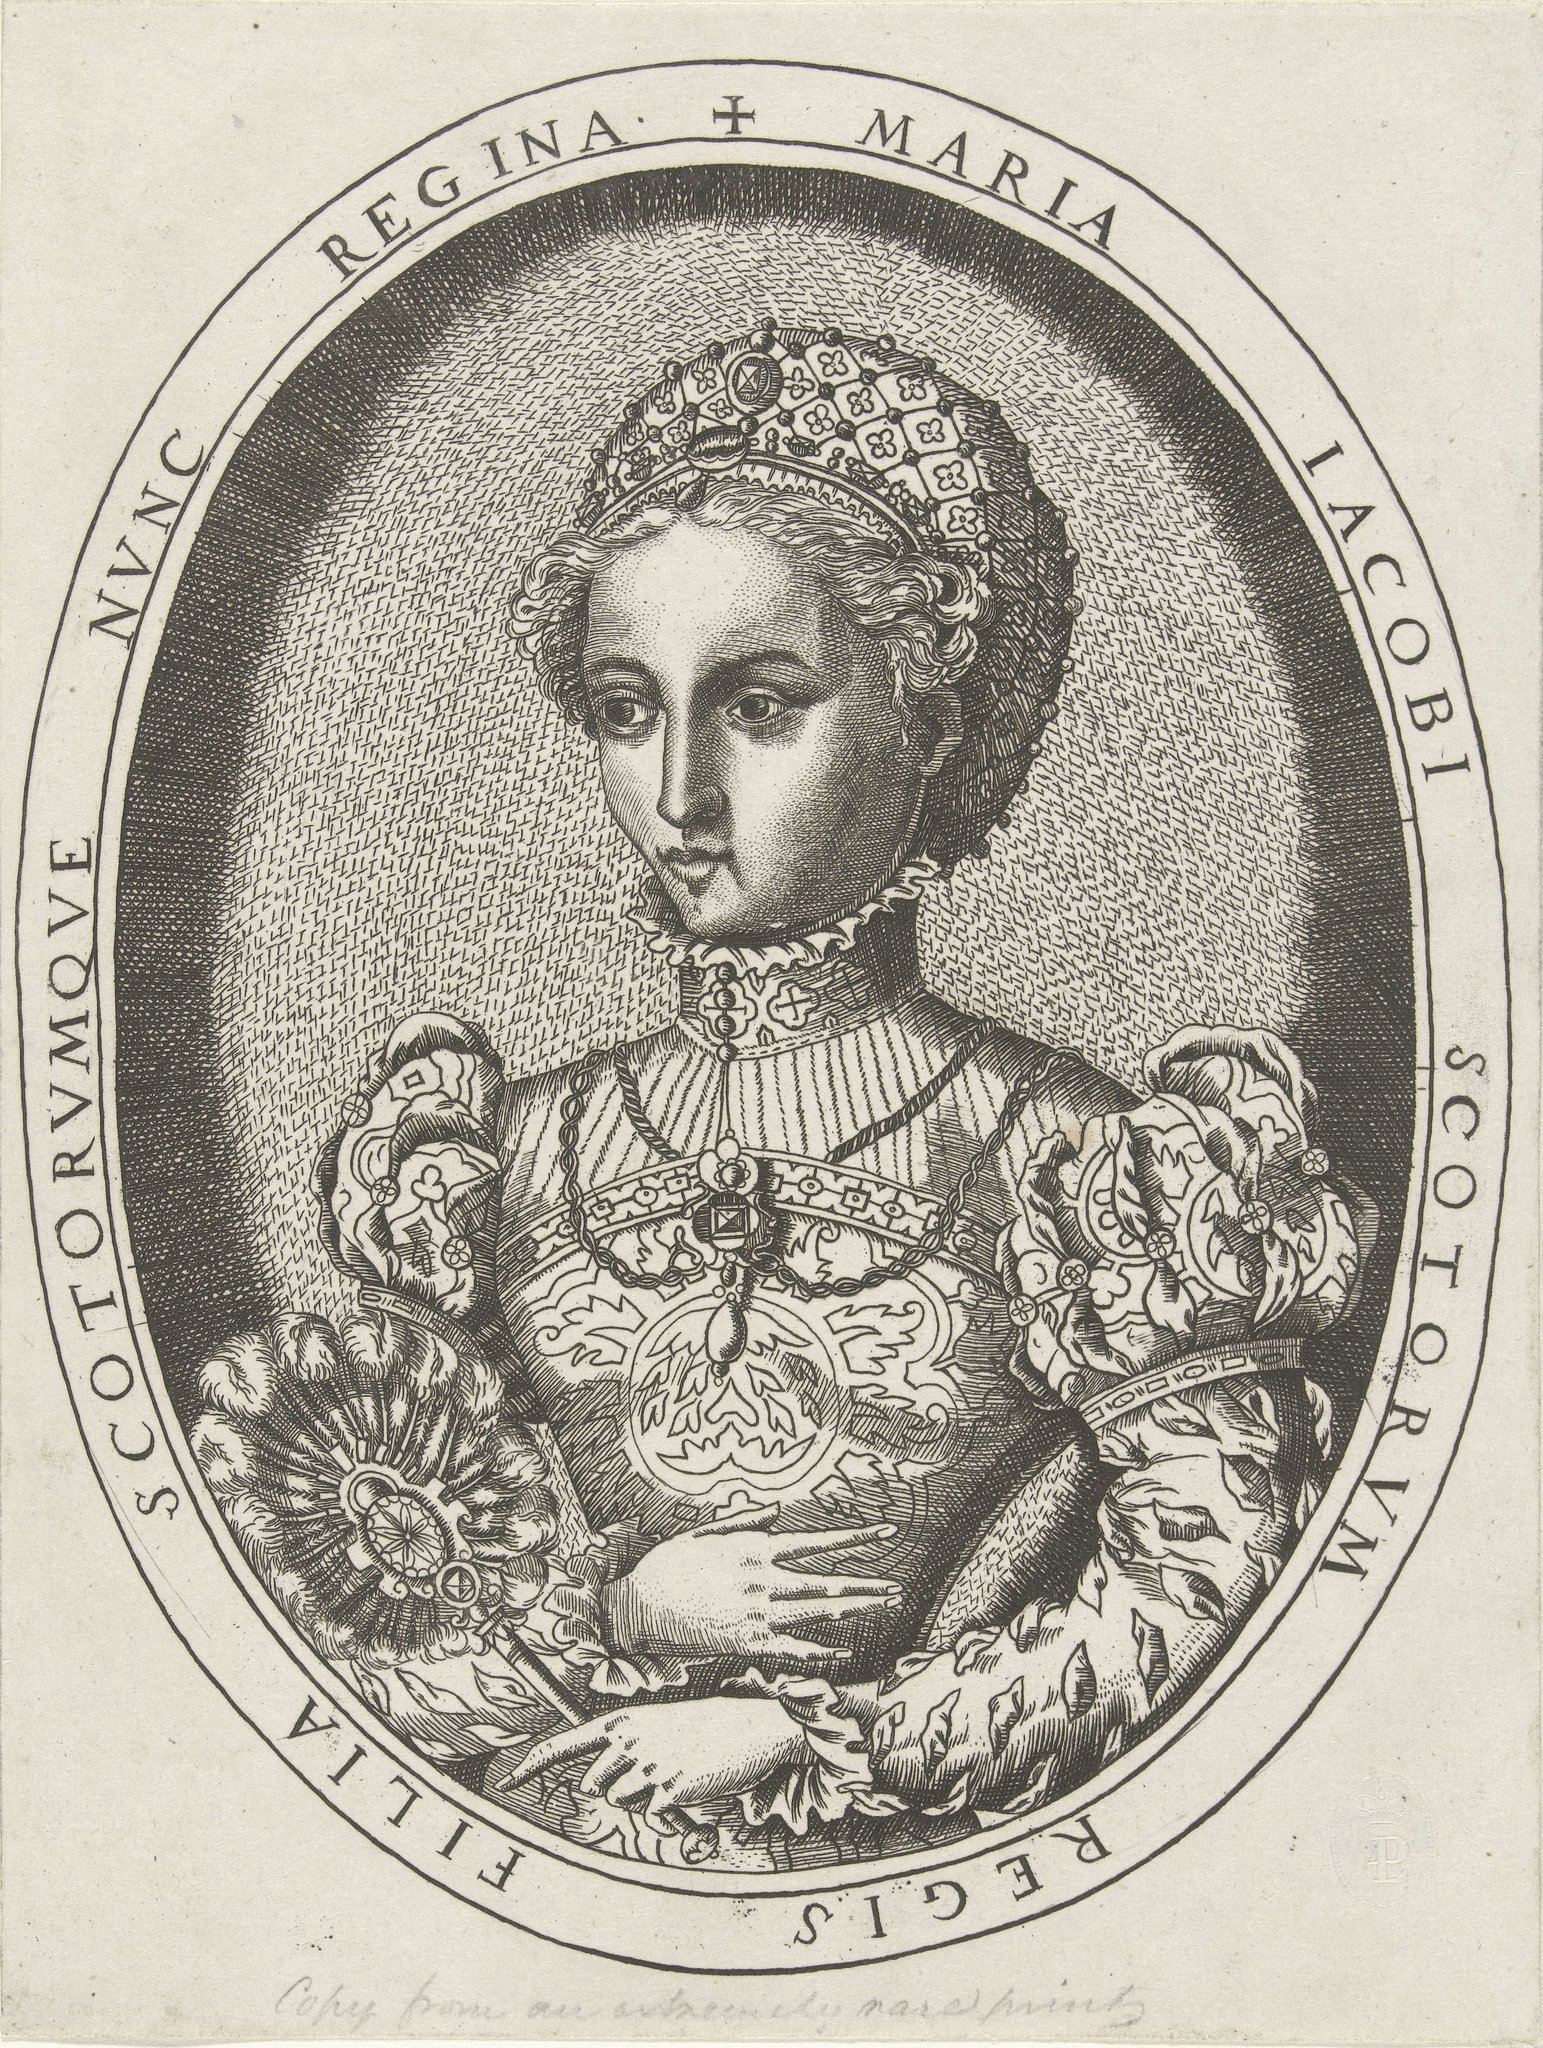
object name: print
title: Portret van Maria I Stuart, koningin van Schotland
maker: Anonymous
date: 1542-1567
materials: paper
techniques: engraving, etching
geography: antwerp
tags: historical persons - bb - woman, neck-gear: collar (+ women's clothes), sleeves: cuffs (+ women's clothes), dress, gown (+ women's clothes), fan, necklace (+ women's clothes), clothing for the upper part of the body (with name) (+ women's clothes)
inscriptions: collector's mark: Lugt 142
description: Portret ten halven lijve naar links van Maria I Stuart, koningin van Schotland in een ovaal met haar naam en titel in het Latijn. Kopie naar de prent uit de serie: portretten van heersers.